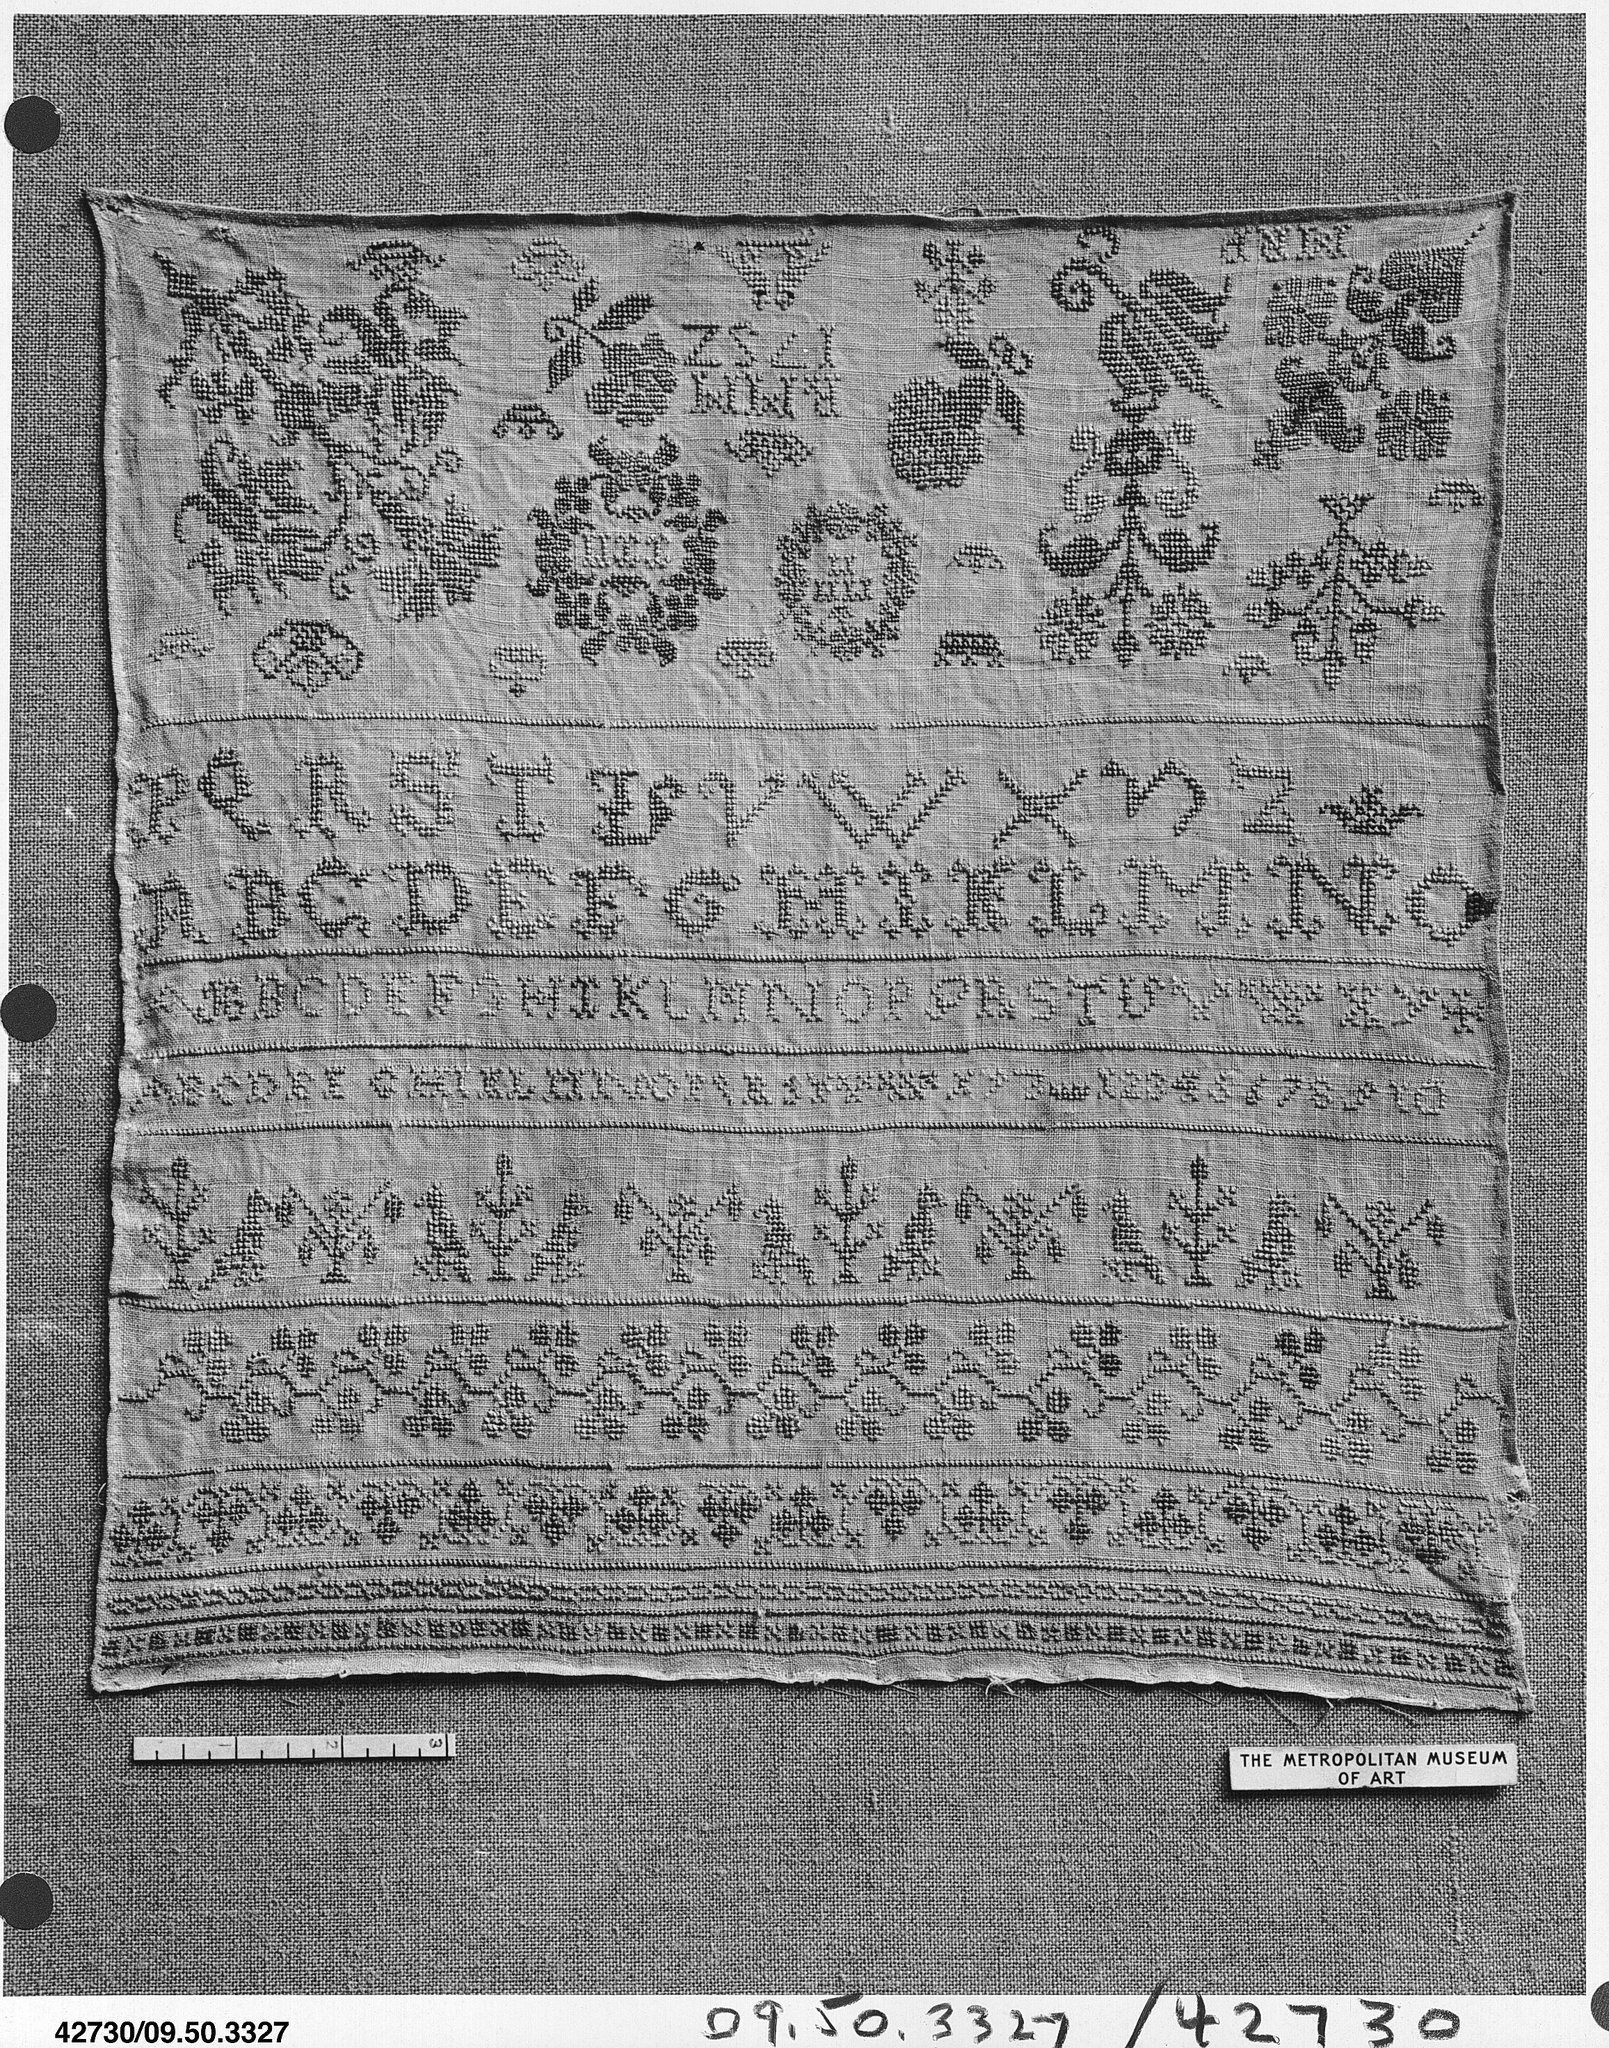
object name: sampler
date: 1752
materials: linen, silk